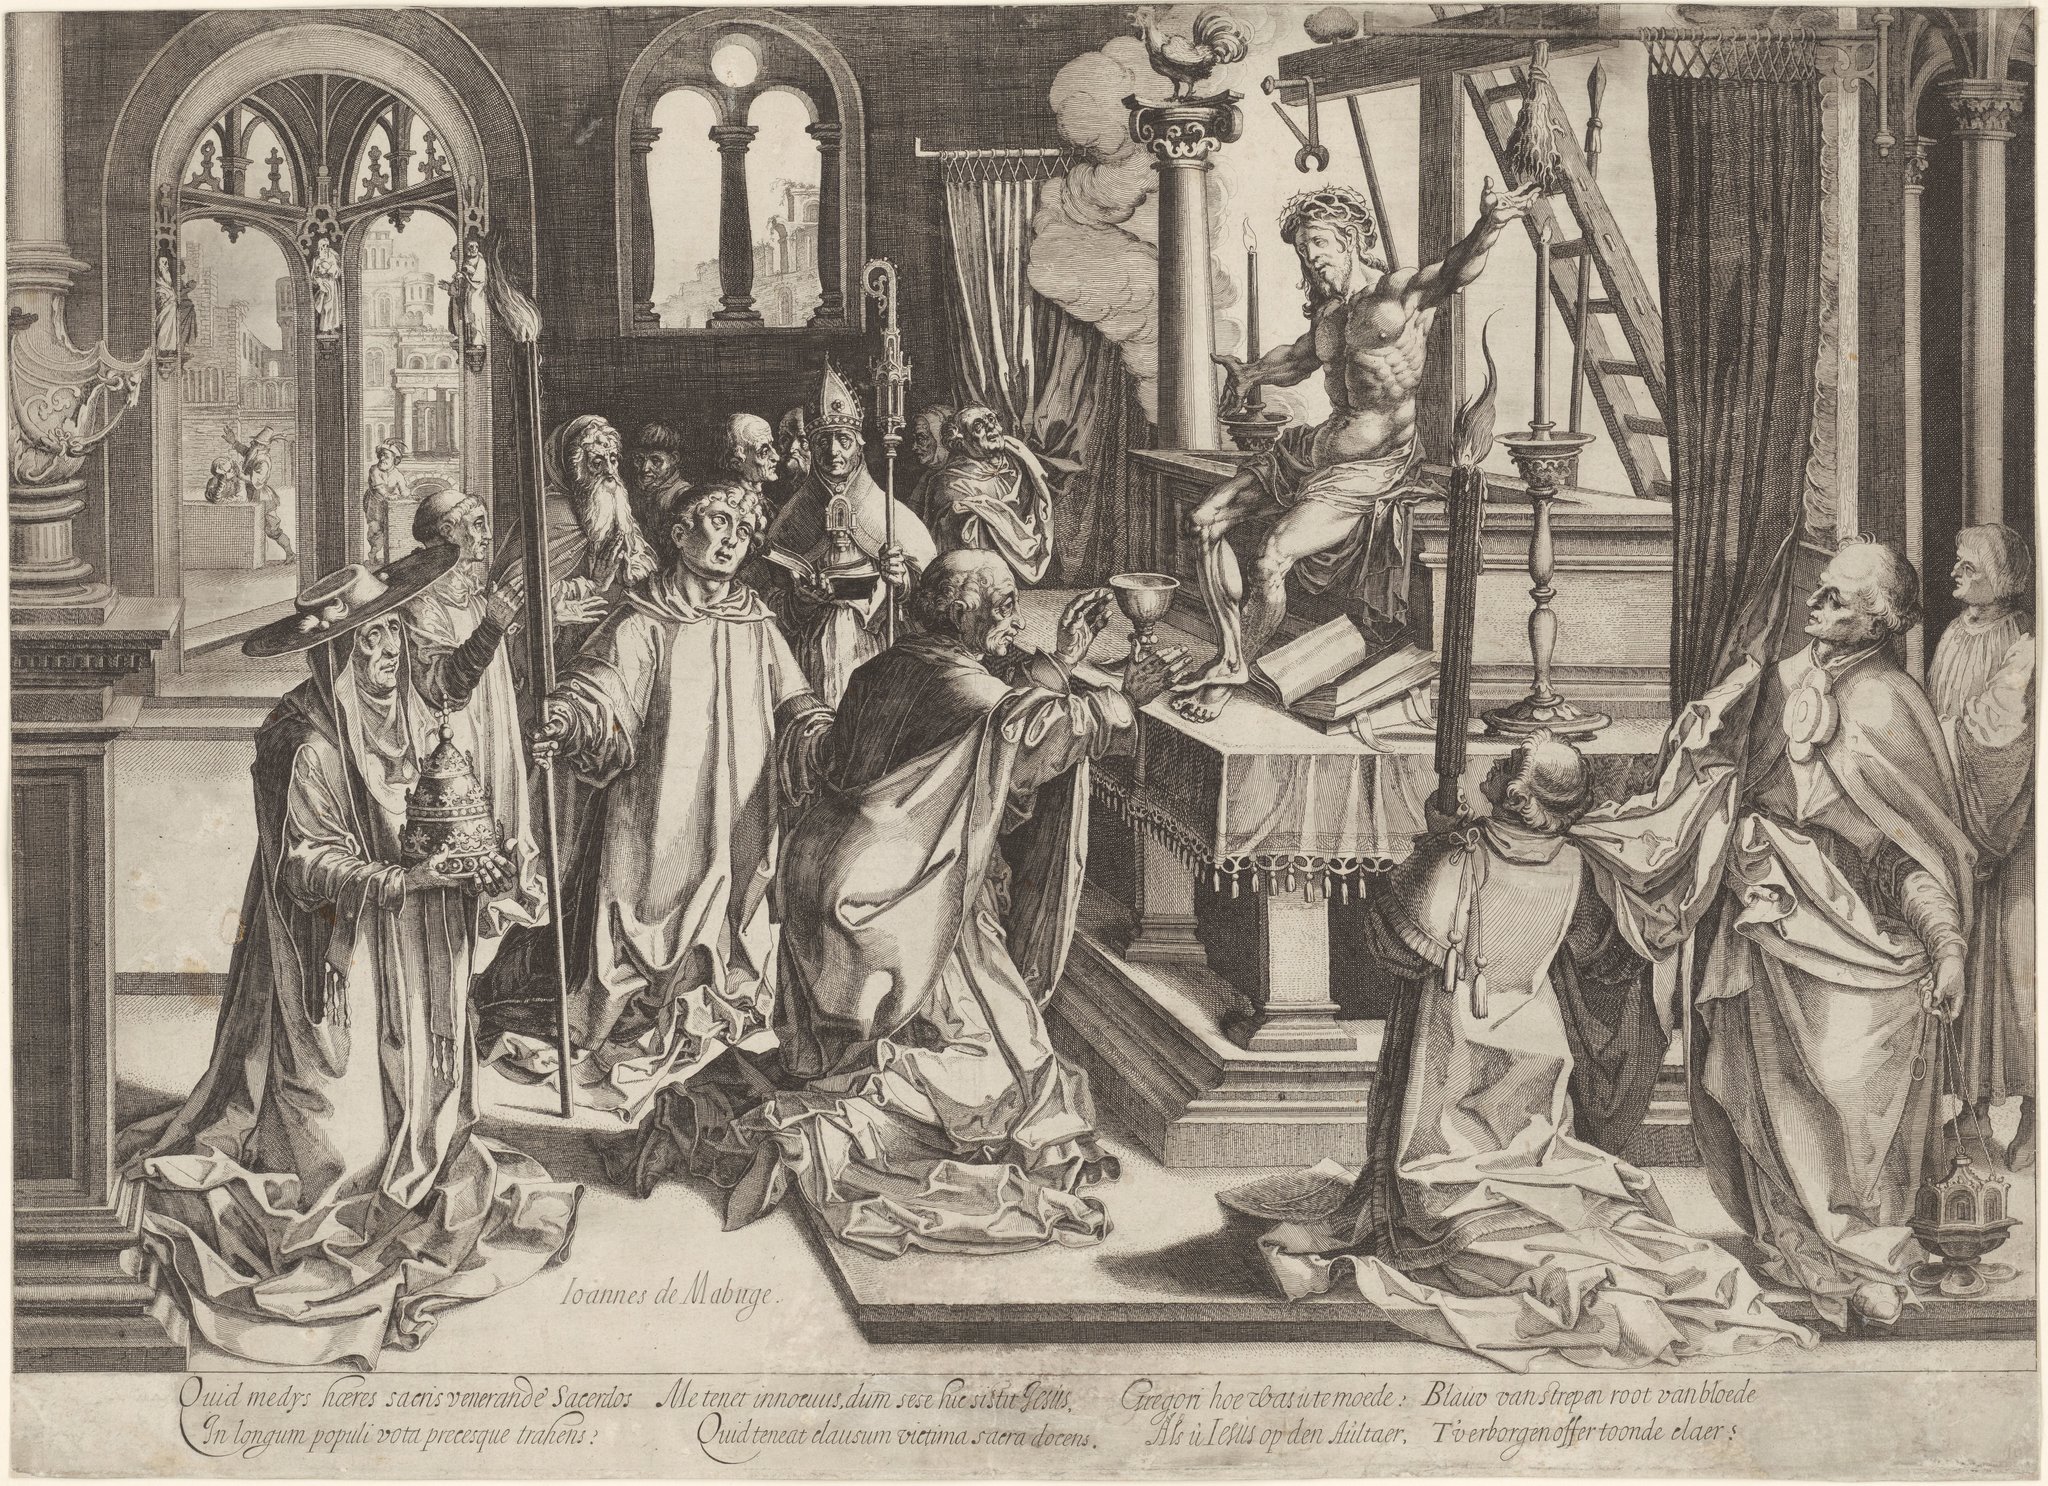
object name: print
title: Gregoriusmis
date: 1595-1628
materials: paper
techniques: etching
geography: northern netherlands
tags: the mass of st. gregory the great: christ appears above the altar with the instruments of the passion; maybe blood spouts from christ's side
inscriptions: collector's mark: Lugt 240, inscription: ‘cijferreeksen’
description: Heilige Gregorius bidt op zijn knieën, terwijl Christus en de passiewerktuigen boven het altaar verschijnen.